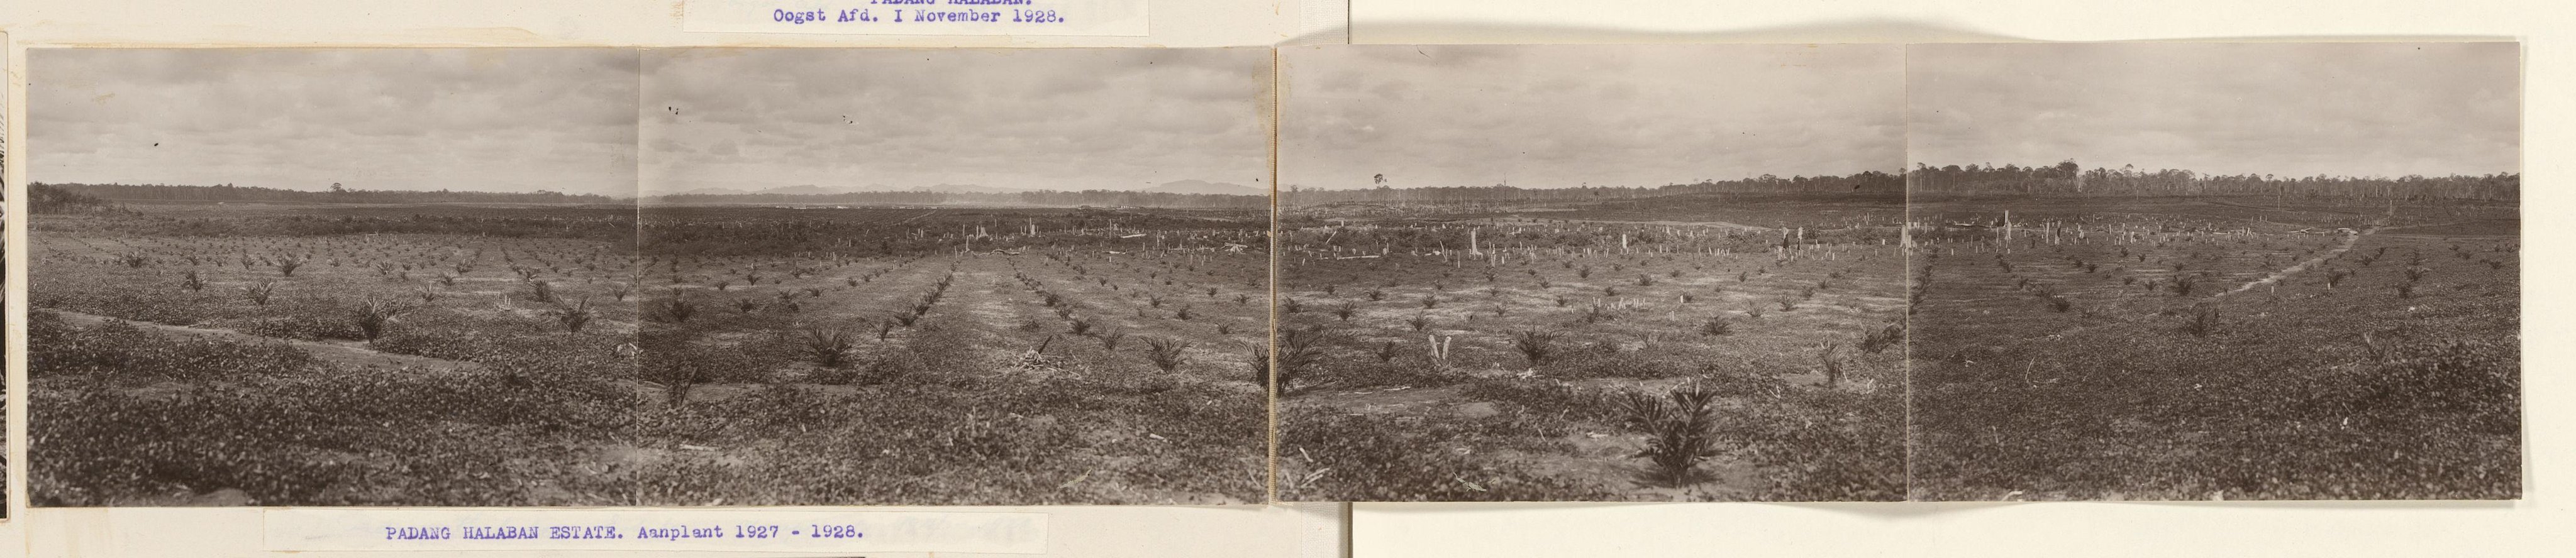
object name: photograph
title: Padang Halaban Estate. Aanplant 1927-1928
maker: Anonymous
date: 1928-1929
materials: photographic support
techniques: collodion silver print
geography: sumatra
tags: plantation, (non-fruit) products of plants or trees: palm oil, sumatra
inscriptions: inscription: ‘Padang Halaban Estate. Aanplant 1927-1928’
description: Weids gezicht op de velden met aanplant van jonge oliepalmen op de plantage Padang Halaban Estate. Panorama opgebouwd uit vier aan elkaar geplakte fotoafdrukken. Onderdeel van het fotoalbum over de plantages Brussel en Pernantian van de Sumatra Caoutchouc Maatschappij op de Oostkust van Sumatra in de jaren 1910-1935.